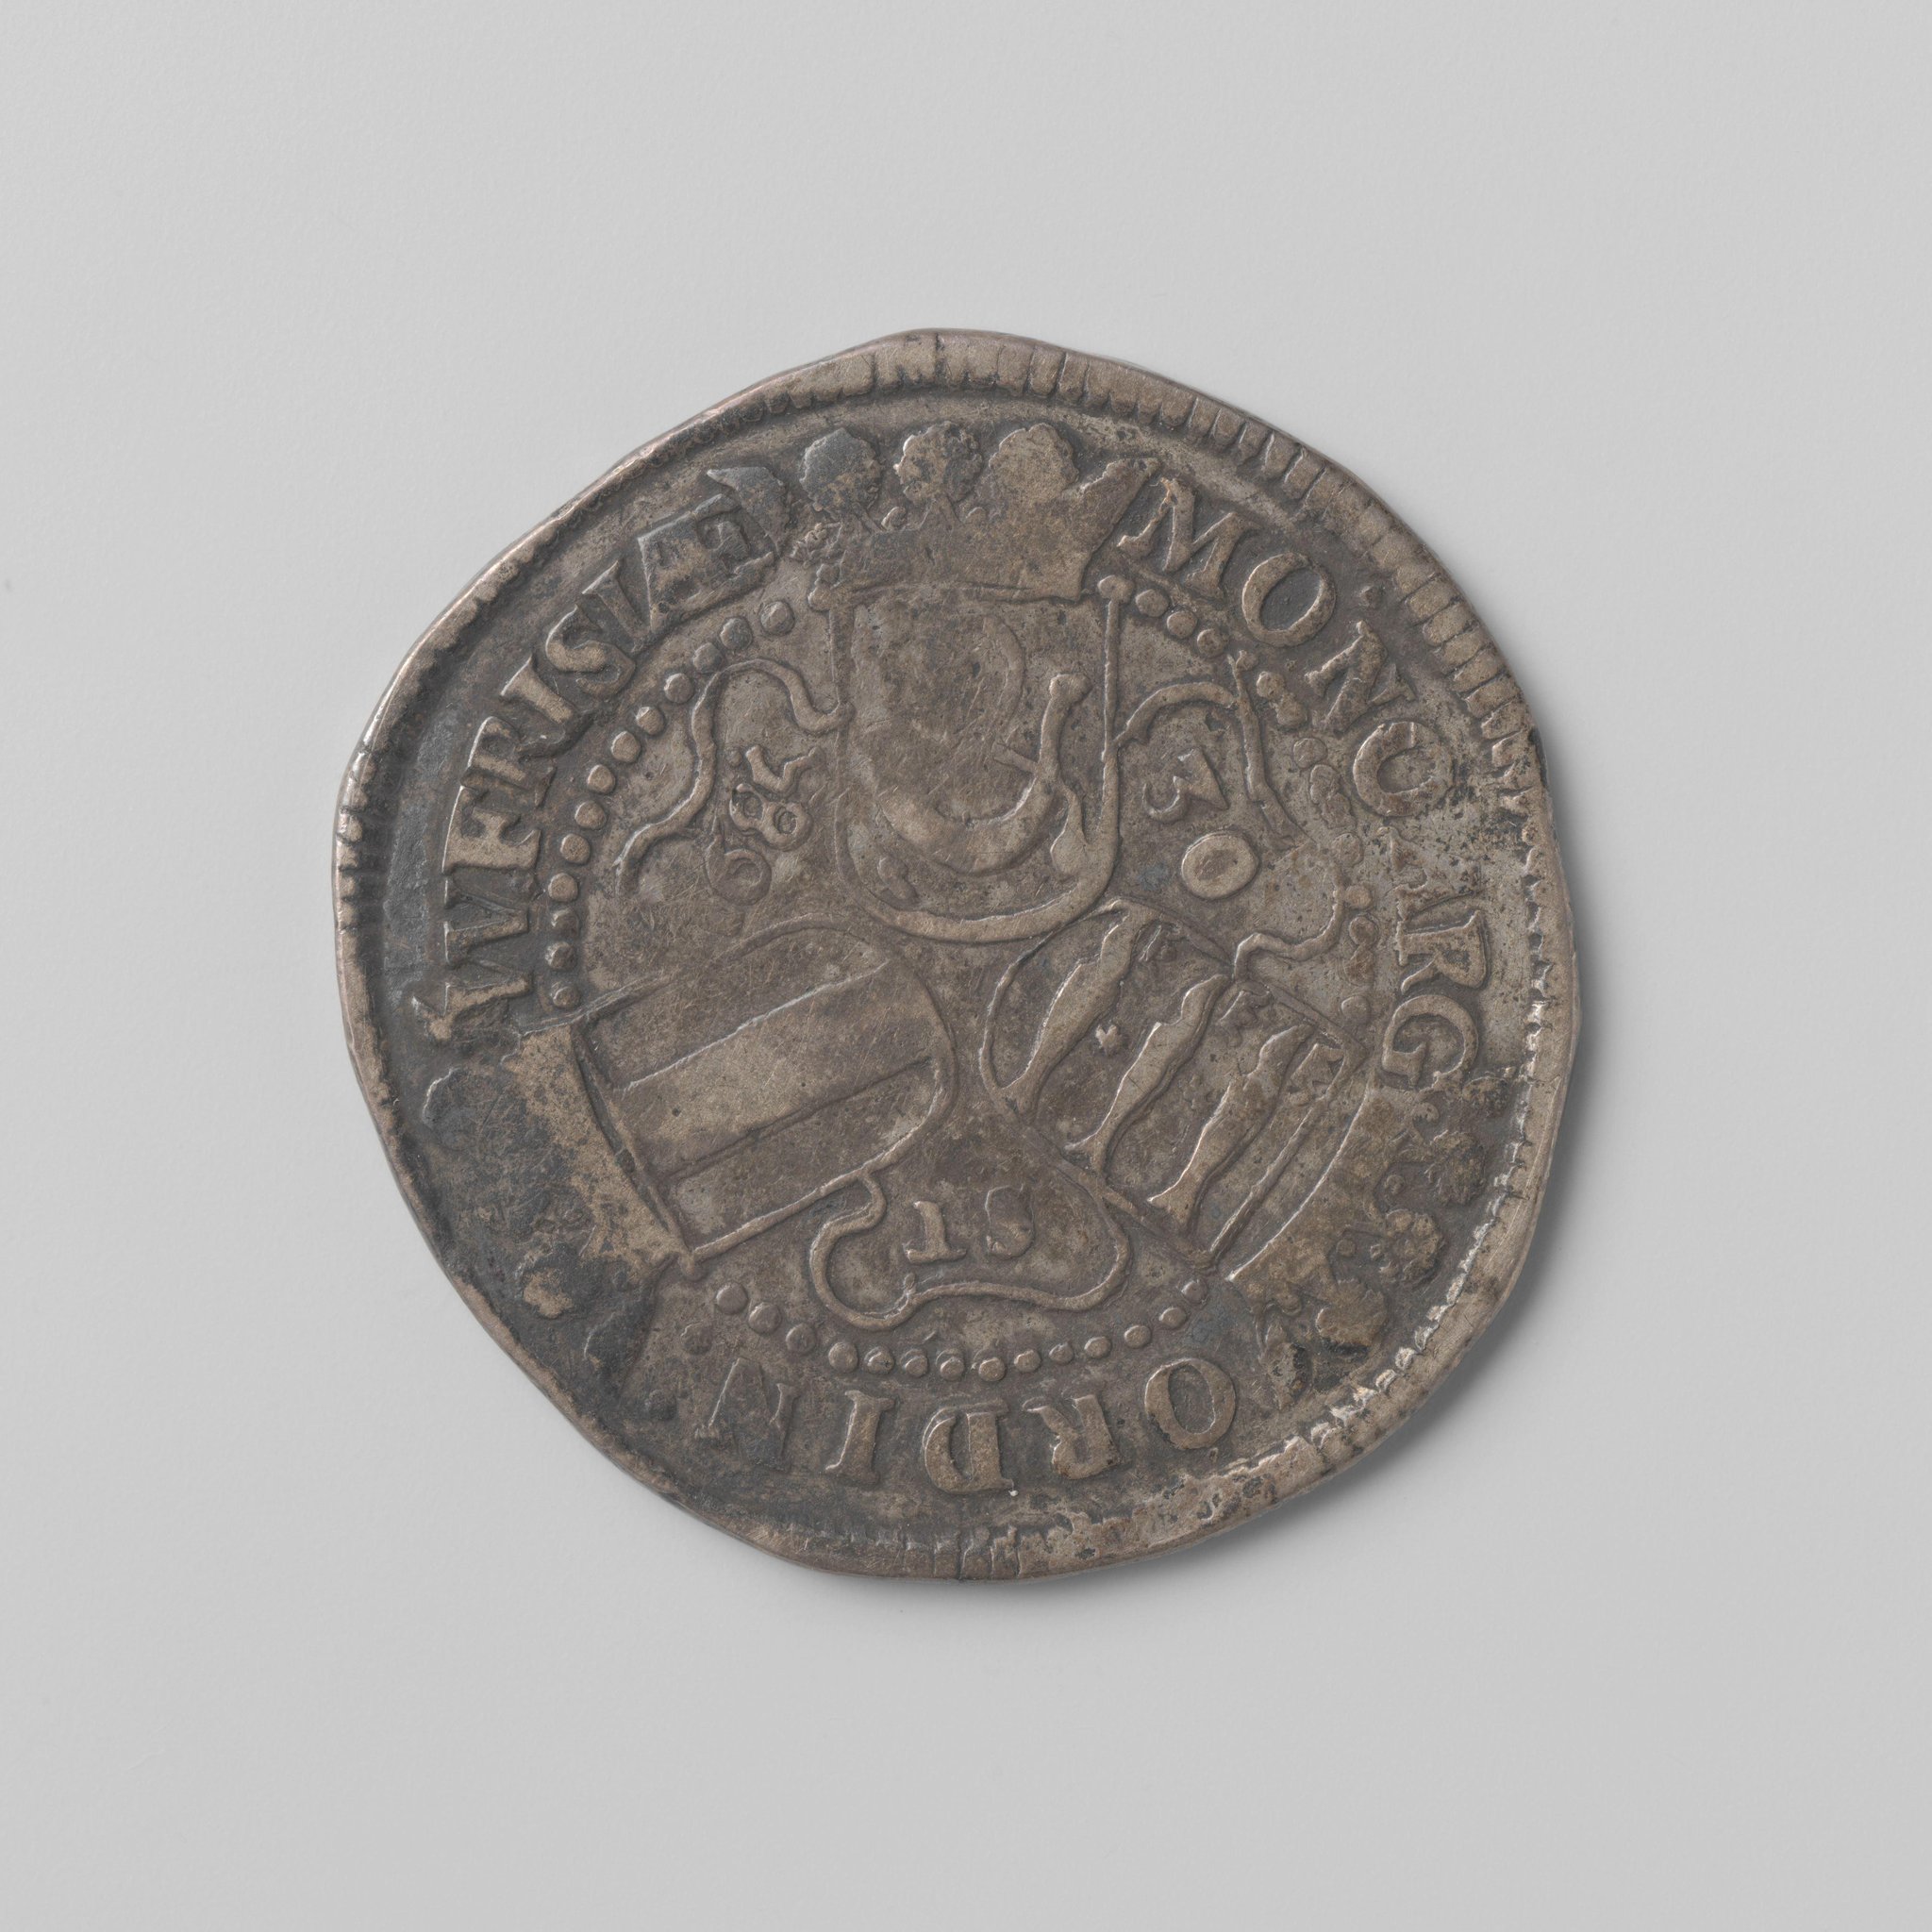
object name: coin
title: West-Friesland, daalder, 1686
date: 1686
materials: silver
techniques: striking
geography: west frisia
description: Zilveren munt. Voorzijde: staande geharnaste ridder naar links kijkend met geheven zwaard in de linker- en gekroond wapenschild van West-Friesland aan lint in rechterhand. Keerzijde: door een lint verbonden wapenschilden van Hoorn, Enkhuizen en Medemblik in een driehoek. Daartussen waarde-aanduiding 30 ST en jaartal.